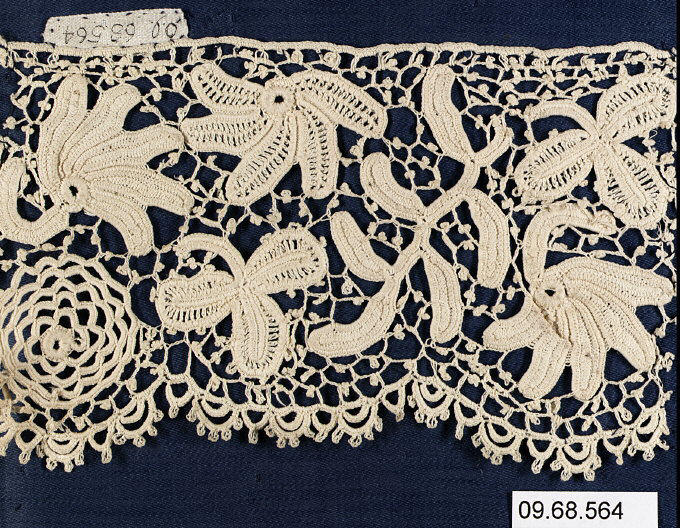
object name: specimen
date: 1801-1900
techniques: crochet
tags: flowers